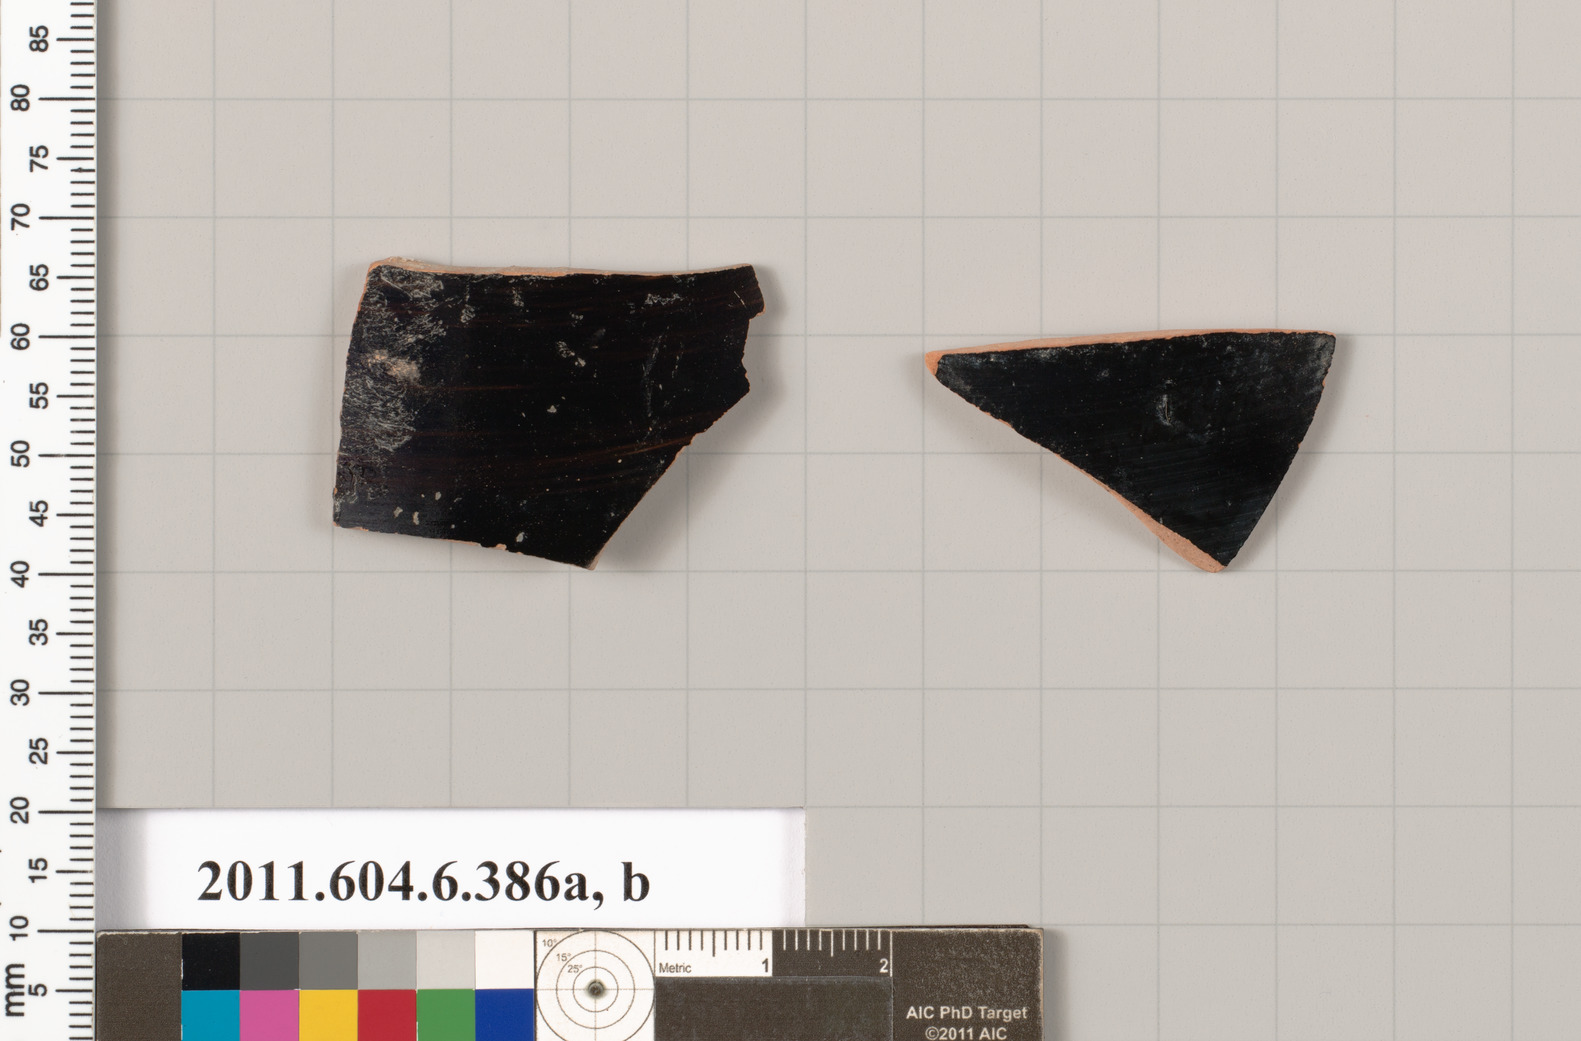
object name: undetermined closed shape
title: Terracotta fragments of closed shapes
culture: greek, attic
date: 600-401 BCE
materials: terracotta